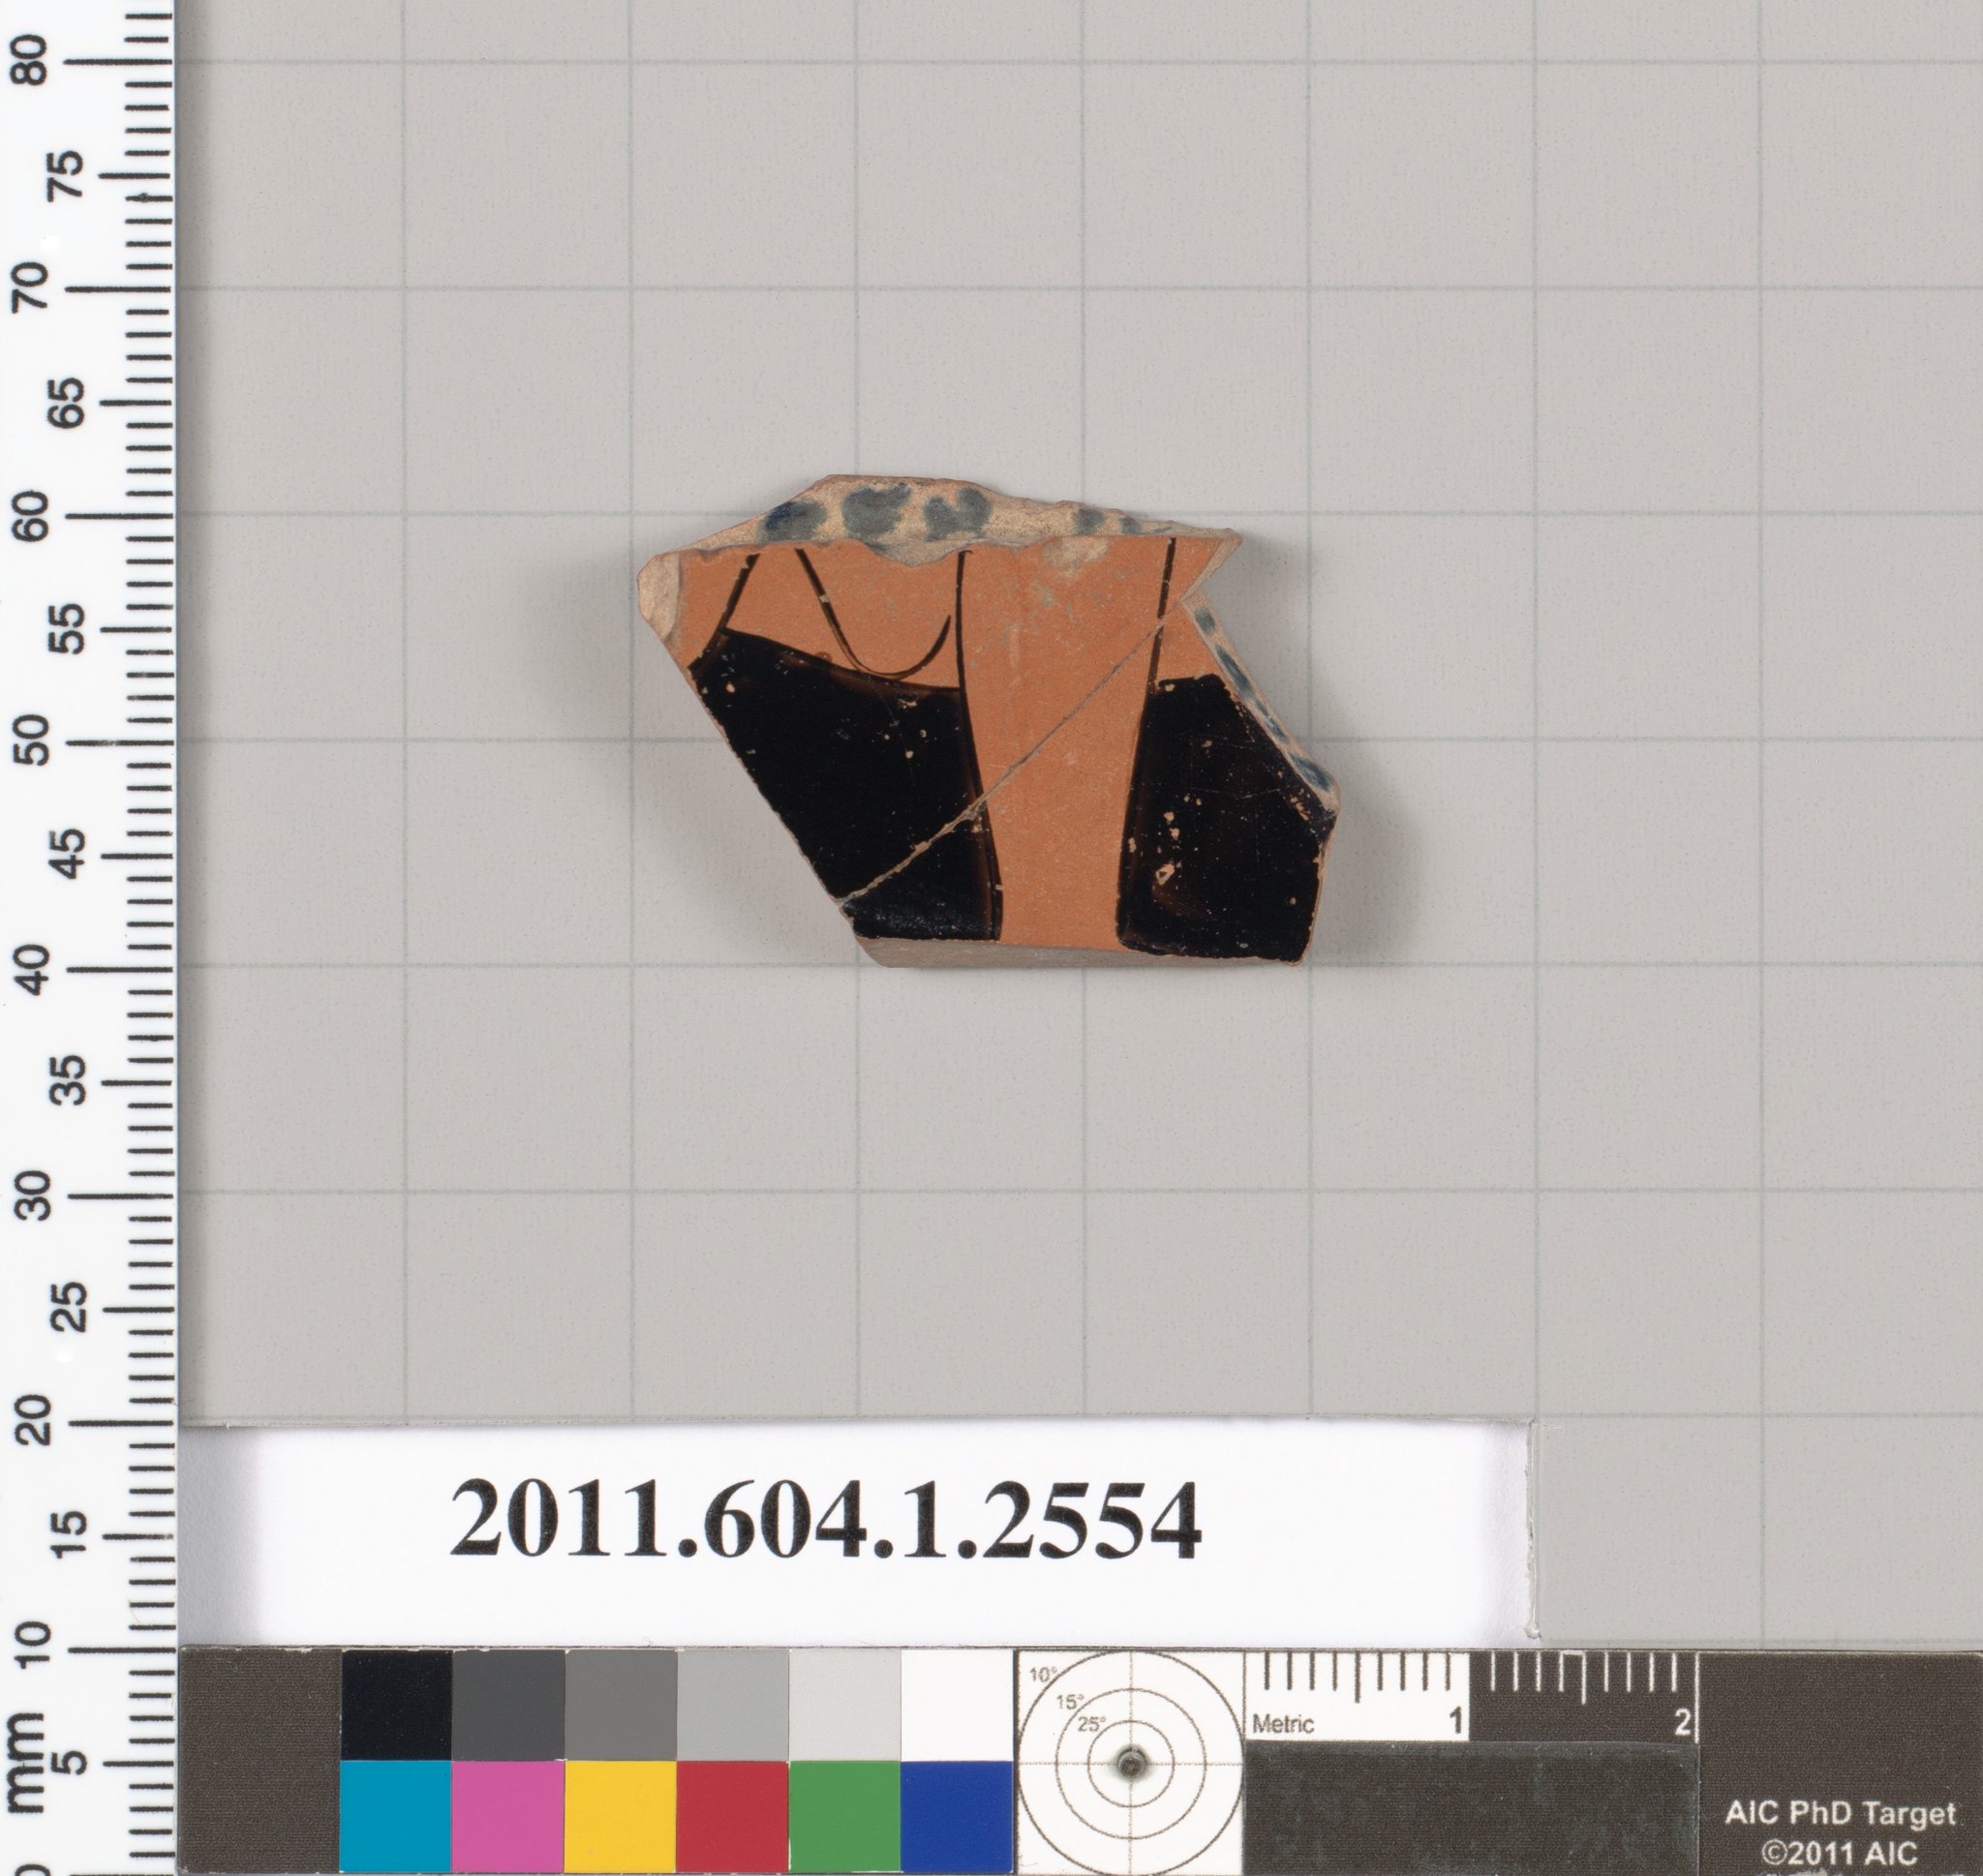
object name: kylix fragment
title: Terracotta fragment of a kylix (drinking cup)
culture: greek, attic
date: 490-480 BCE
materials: terracotta